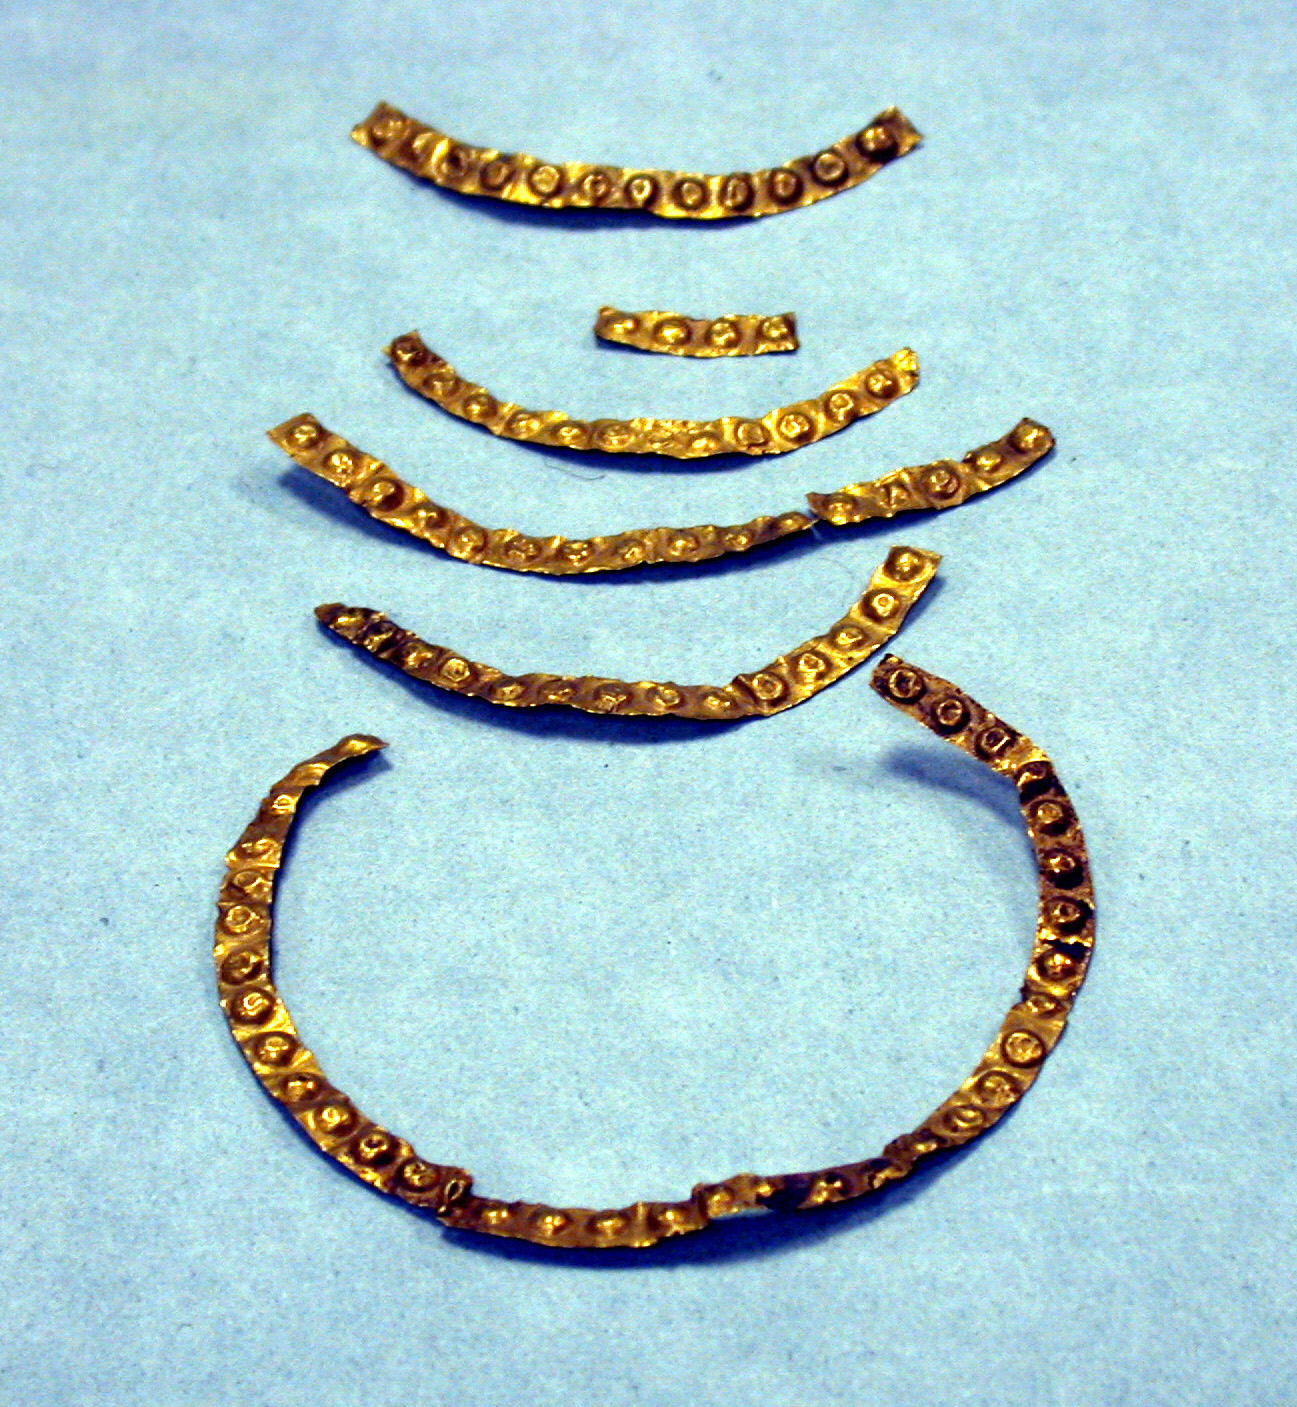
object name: ornament fragment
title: Seven Hammered Gold Strips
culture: peruvian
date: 200-900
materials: gold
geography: peru